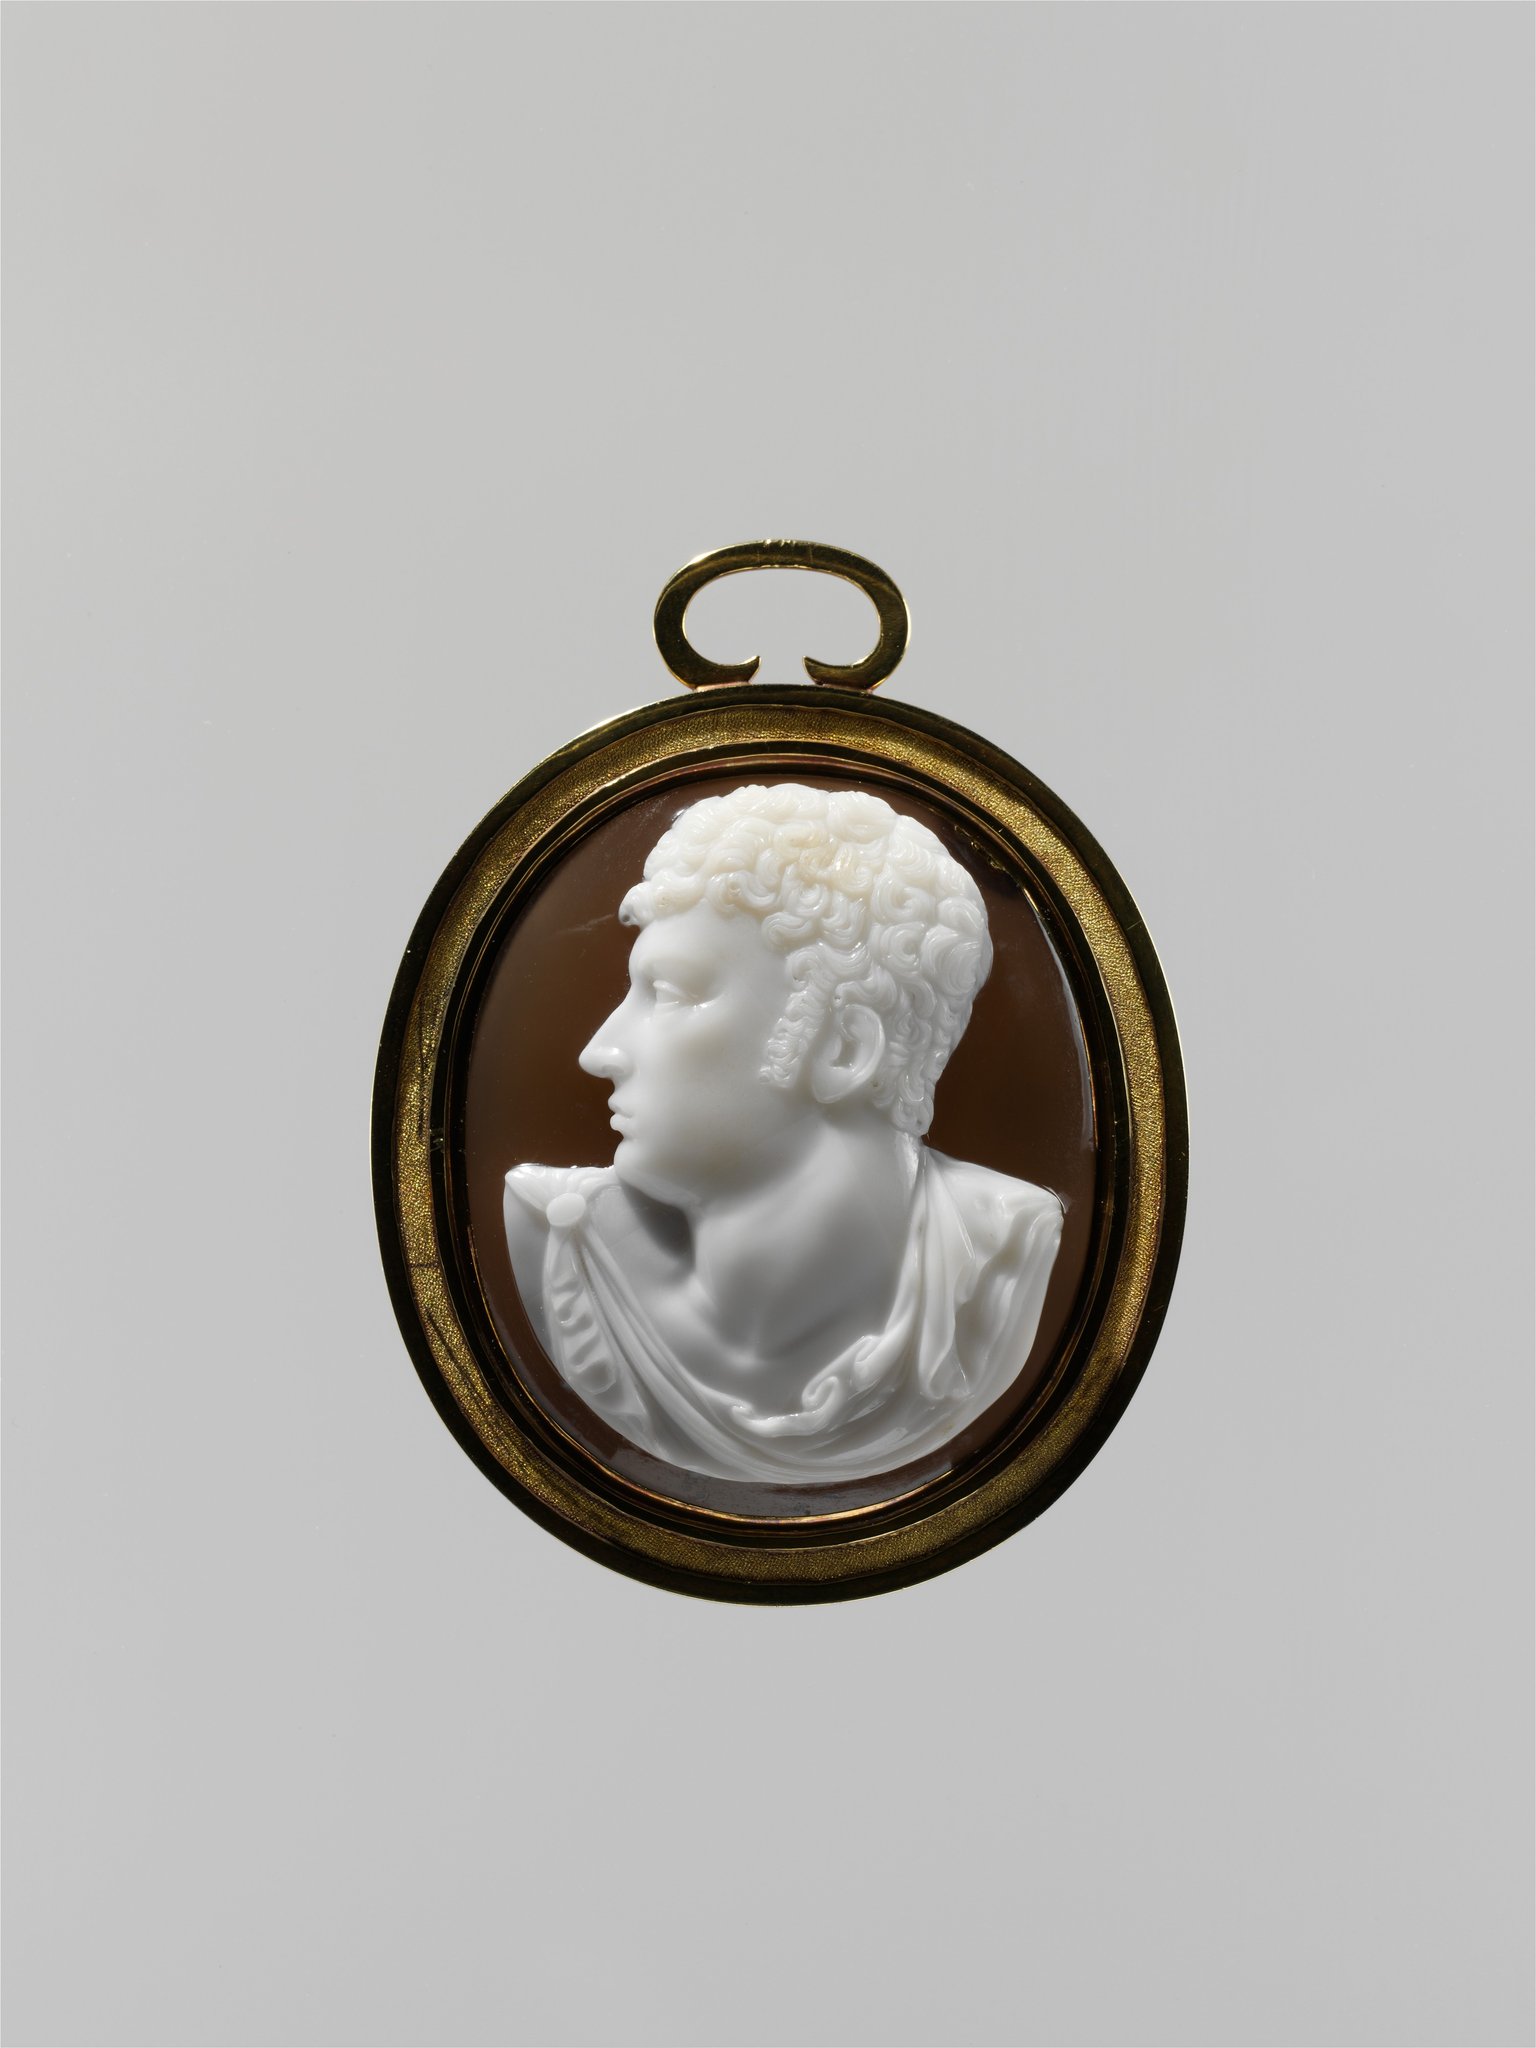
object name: cameo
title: George Gordon, Lord Byron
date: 1820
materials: gold, gemstone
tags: men,profiles